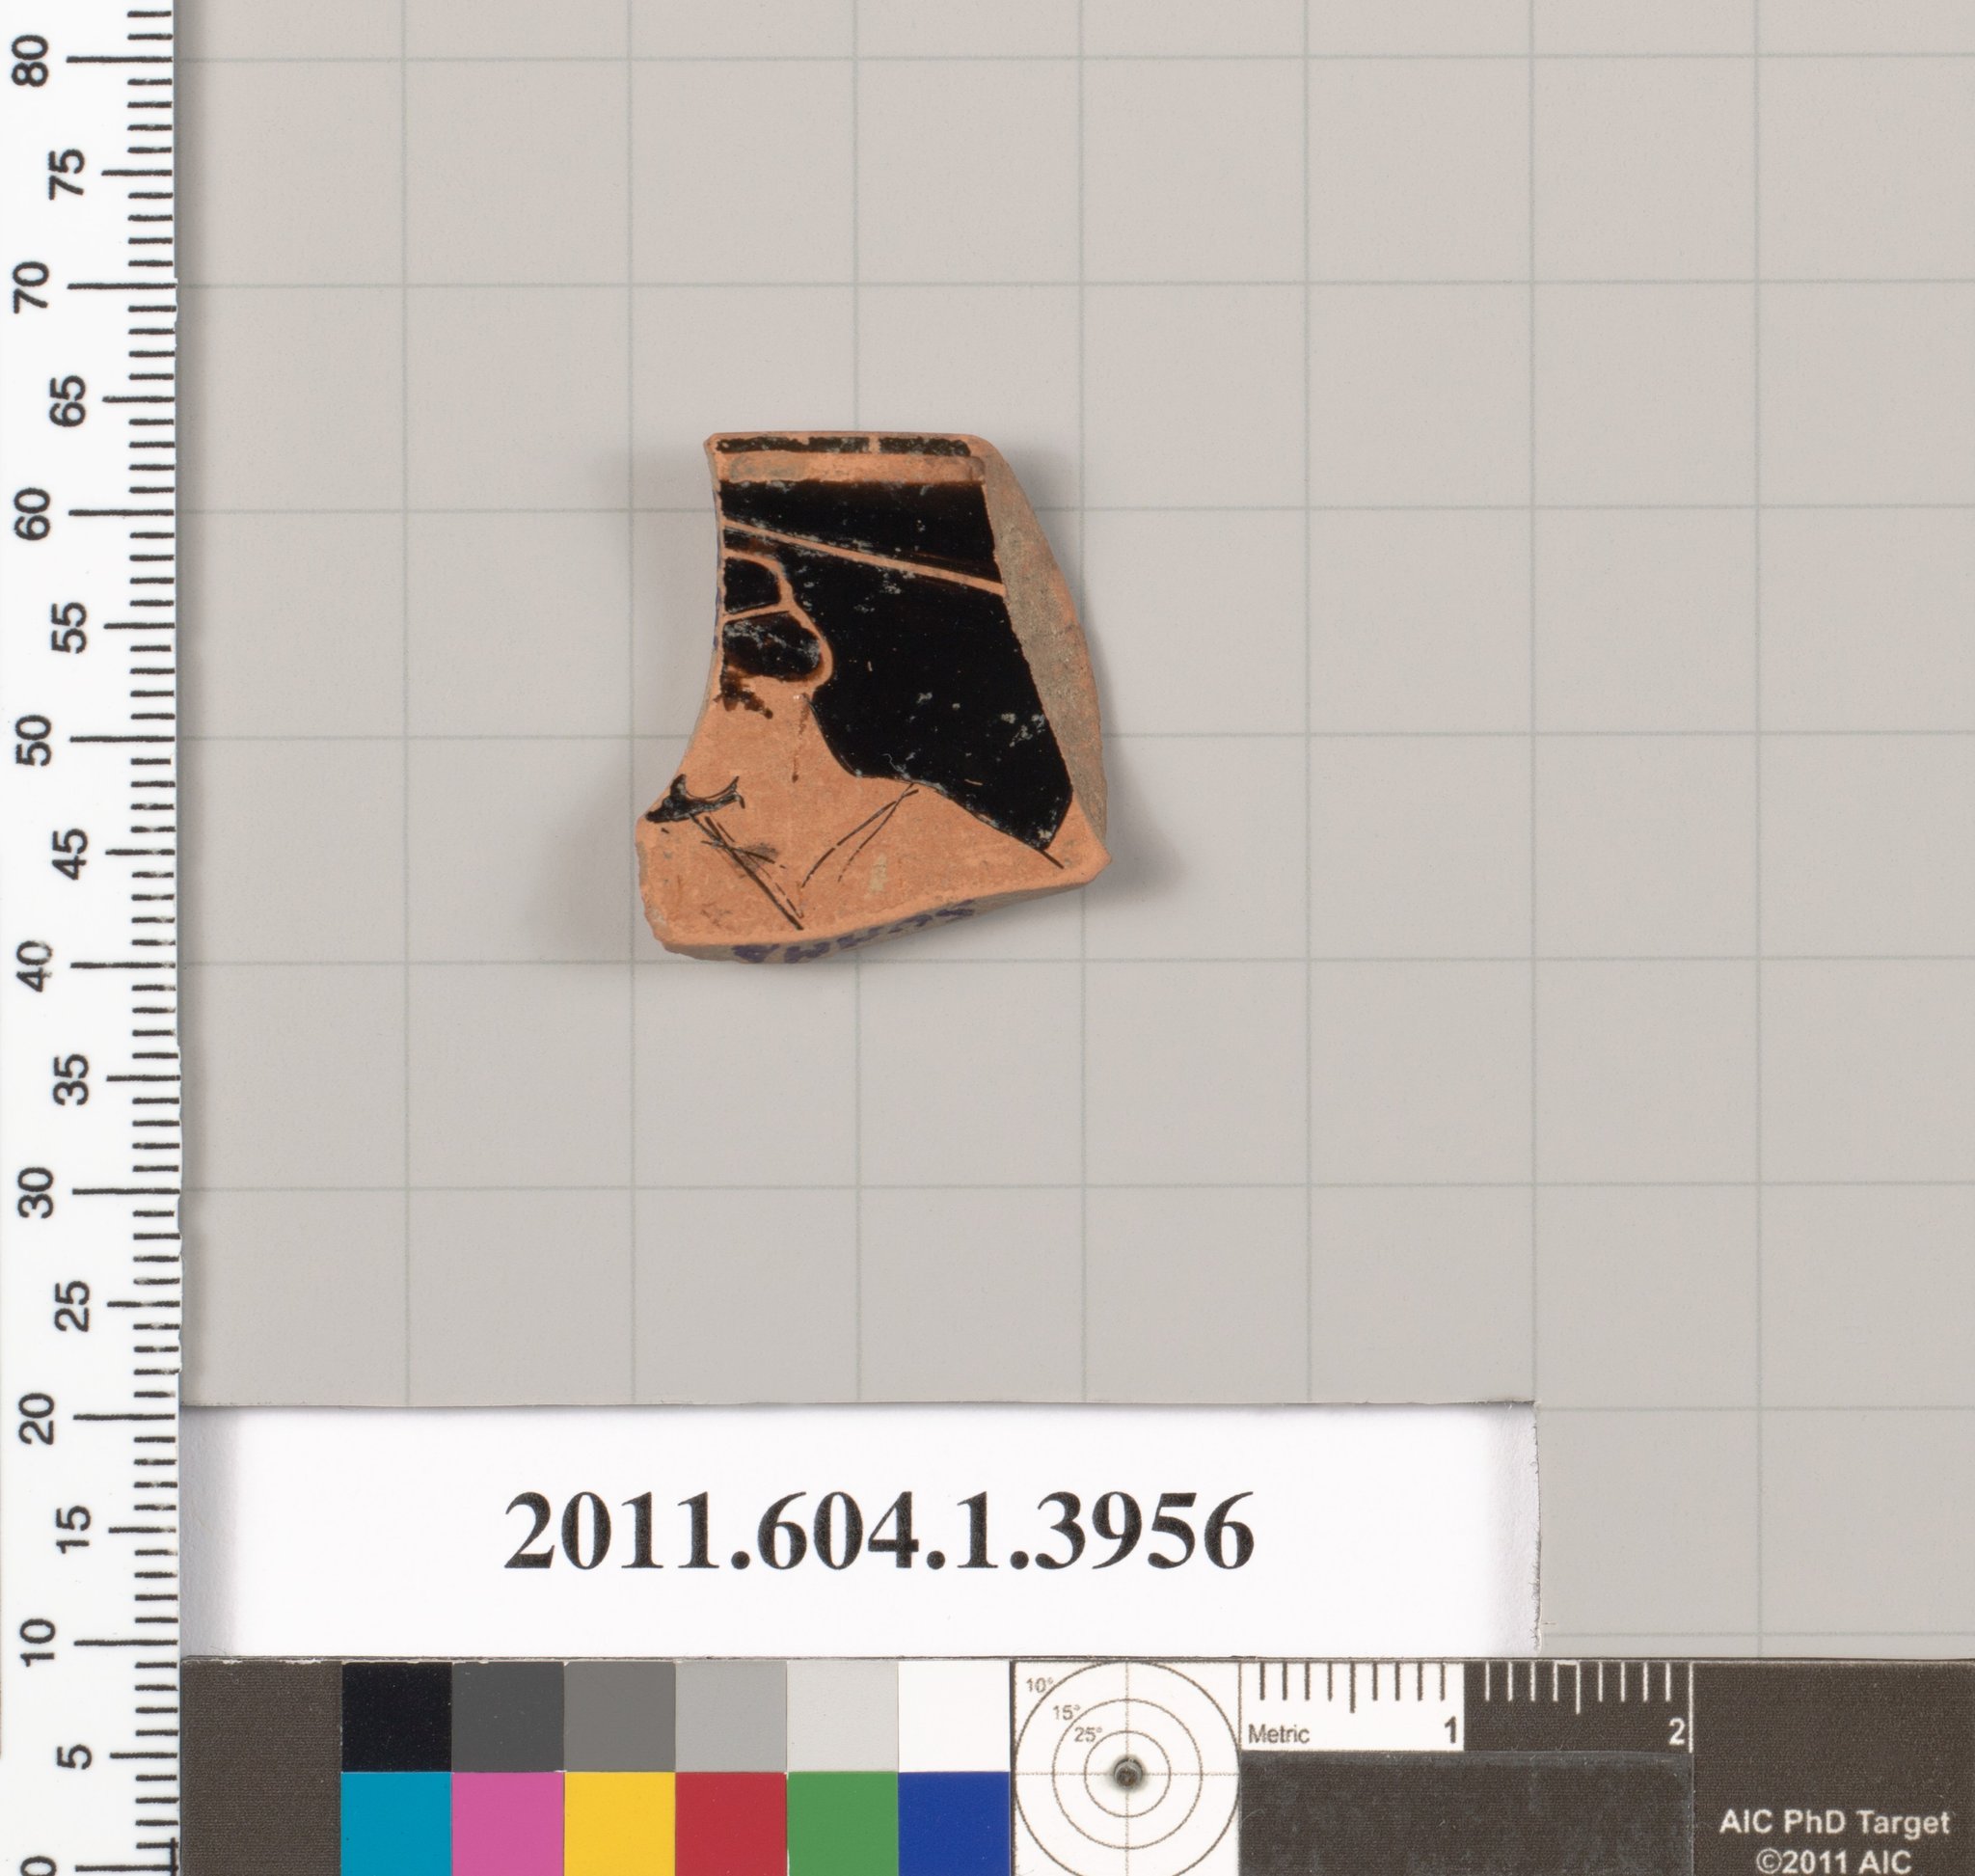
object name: kylix fragment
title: Terracotta rim fragment of a kylix (drinking cup)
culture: greek, attic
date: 475-451 BCE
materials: terracotta